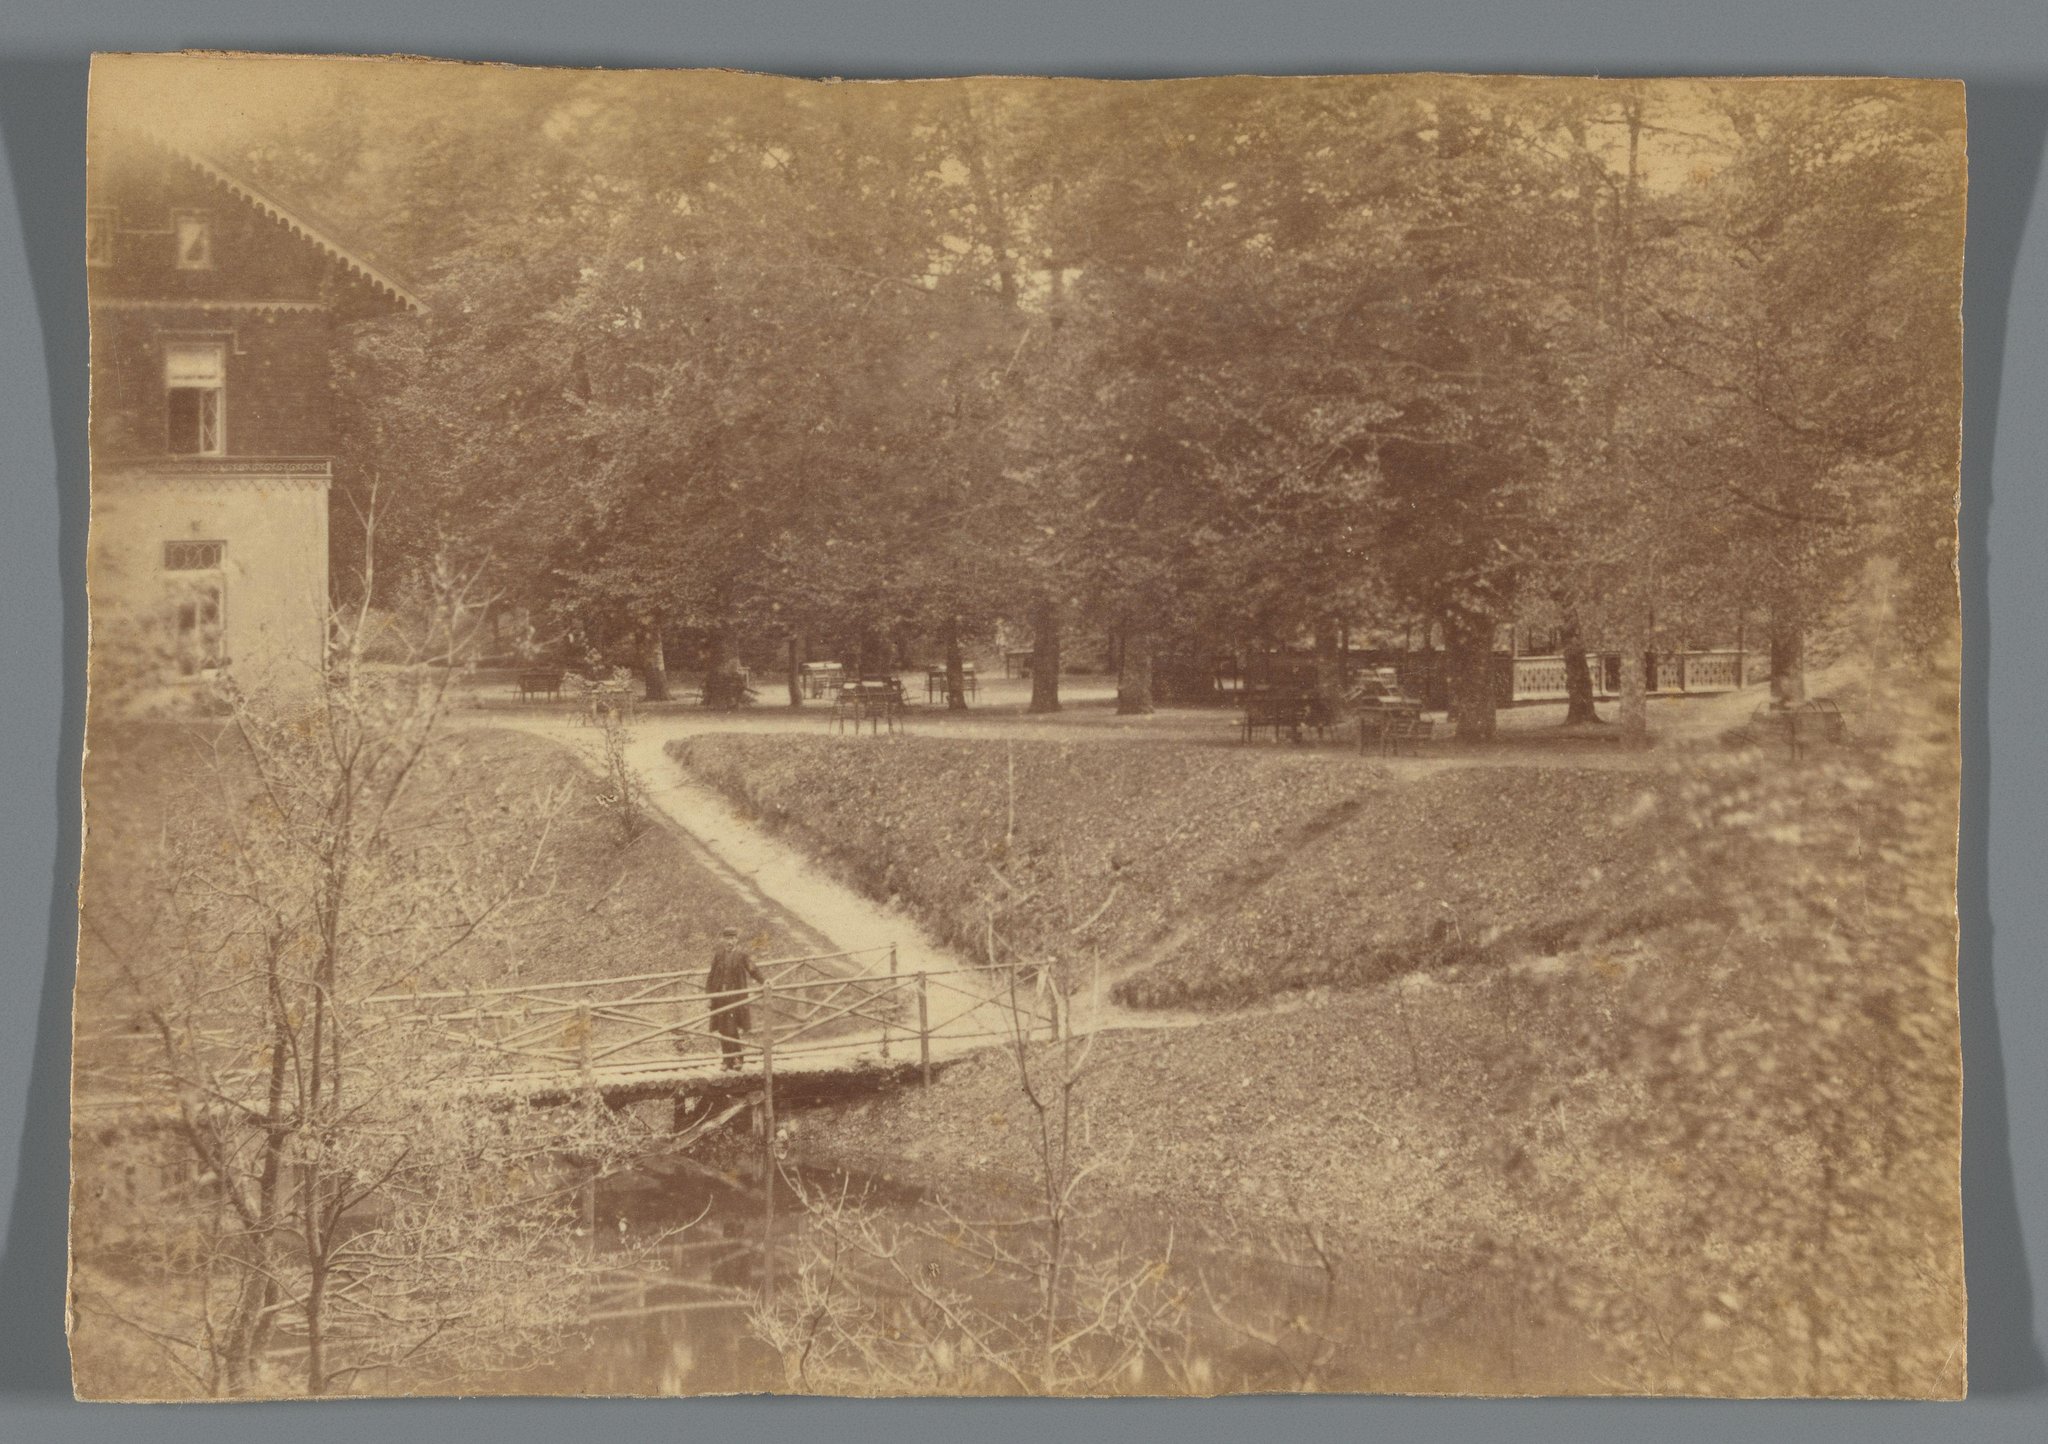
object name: photograph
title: Gezicht op een landgoed met brug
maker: Anonymous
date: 1870-1900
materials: cardboard, paper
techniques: albumen print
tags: garden